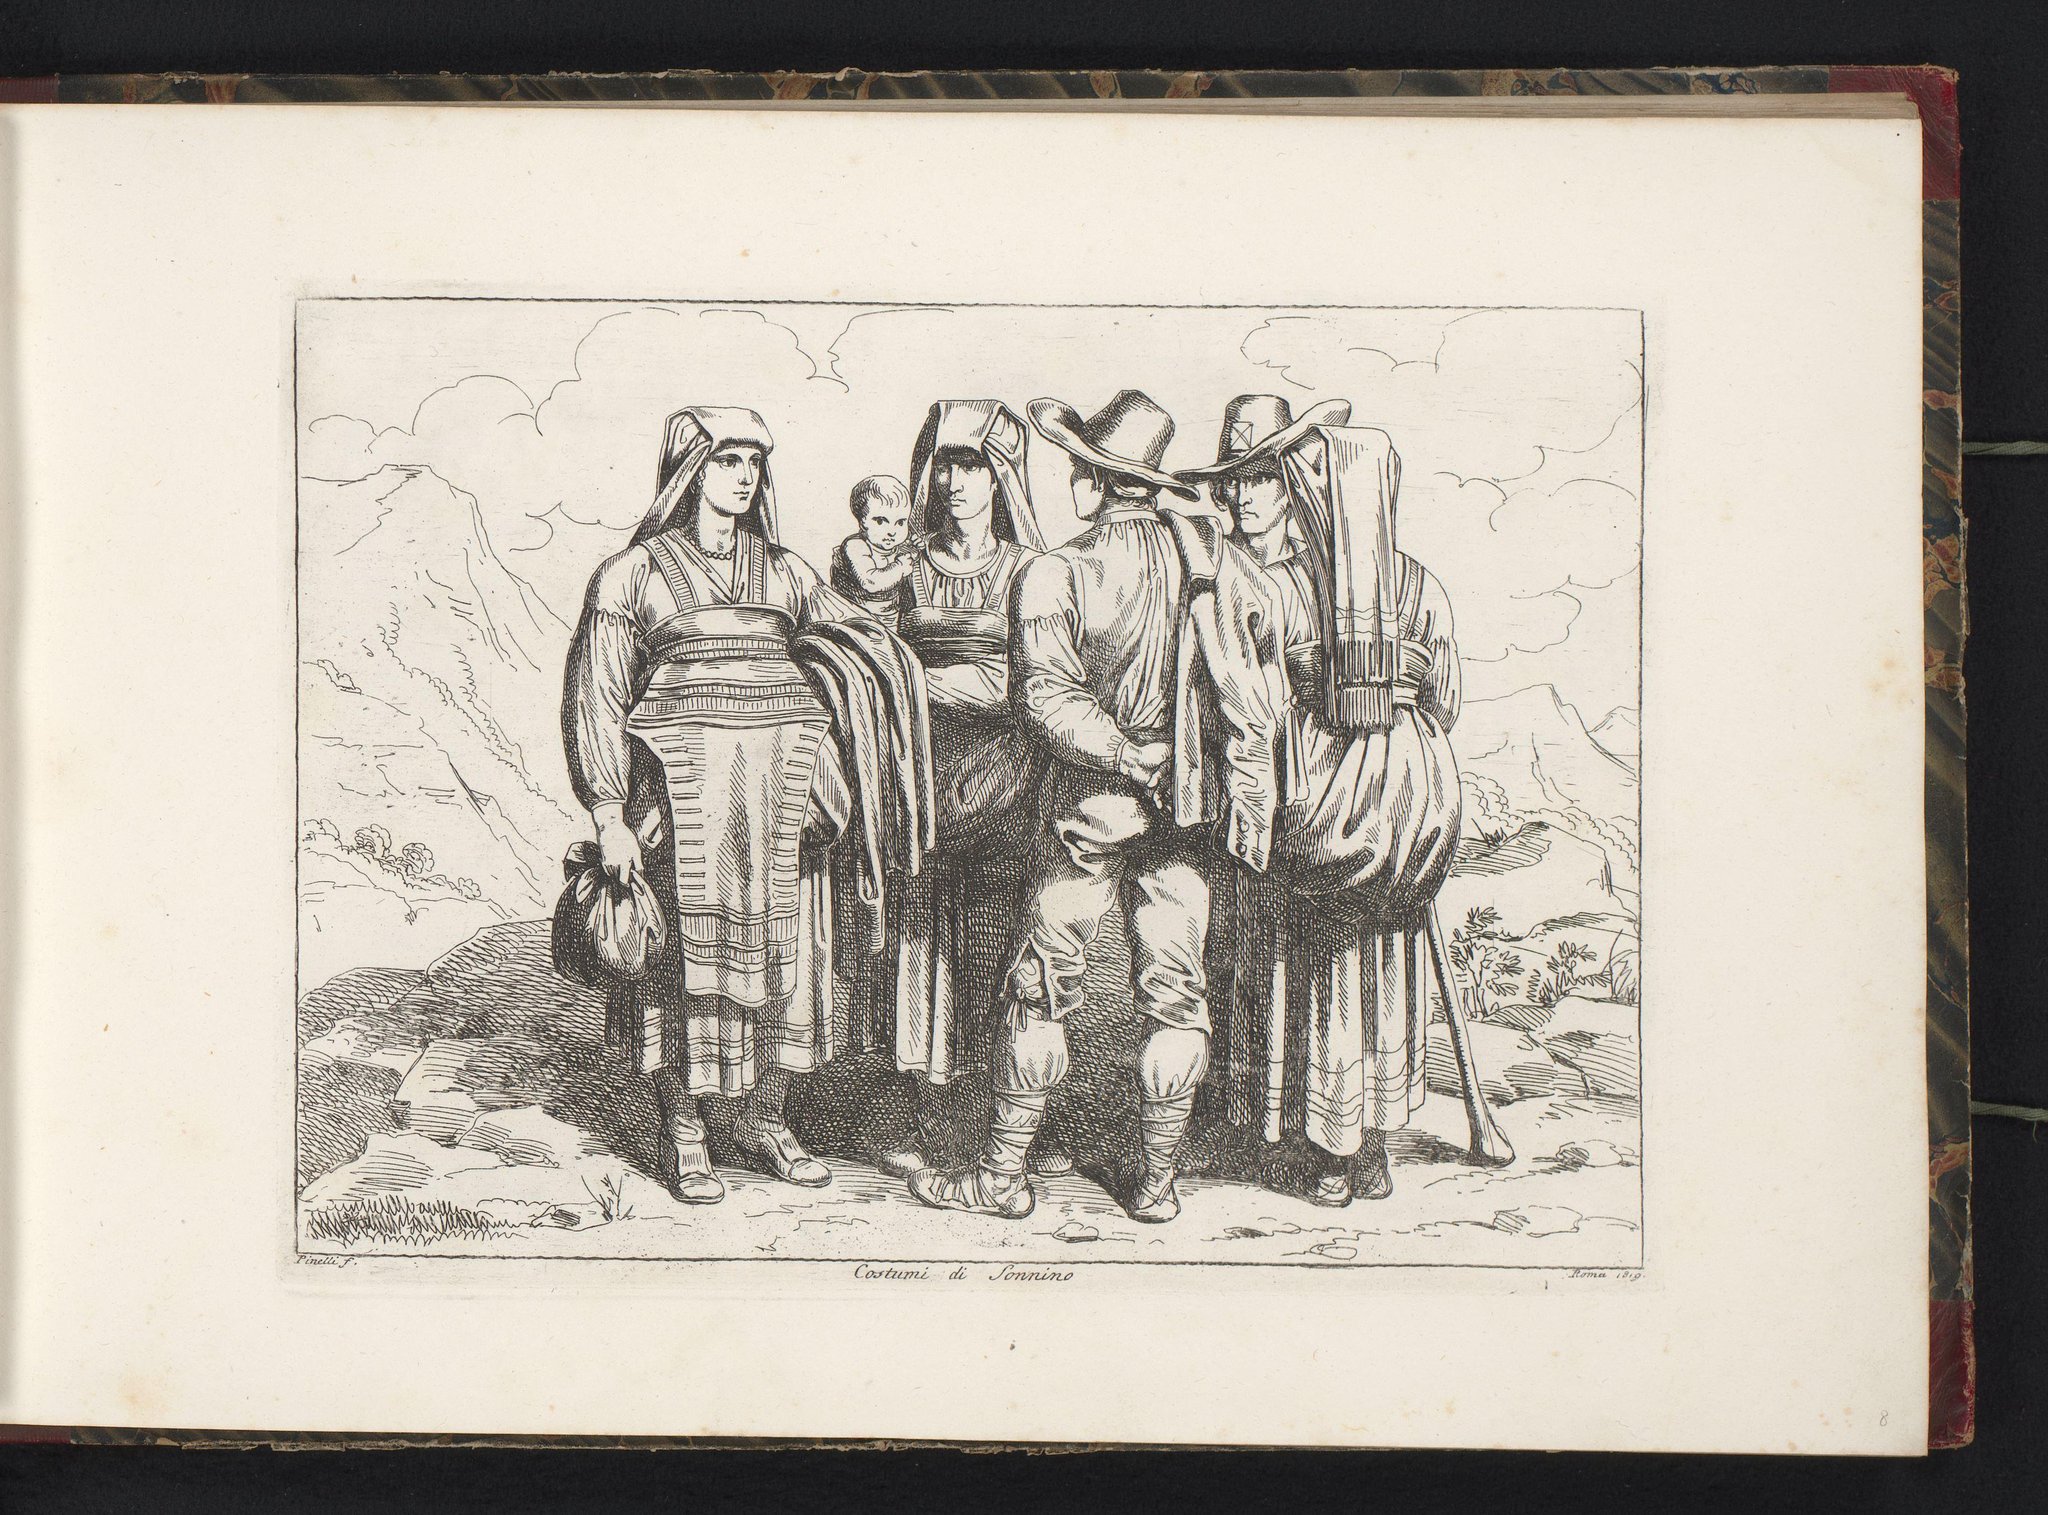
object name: album leaf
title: Drie vrouwen en twee mannen uit Sonnino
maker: bartolomeo pinelli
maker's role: draughtsman, print maker, sculptor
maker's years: 1781-1835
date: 1819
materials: paper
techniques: etching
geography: rome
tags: city-view, and landscape with man-made constructions, folk costume, regional costume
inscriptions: date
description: In een landschap staan drie vrouwen en twee mannen. Eén van de vrouwen houdt een kind vast. De prent maakt deel uit van een album.